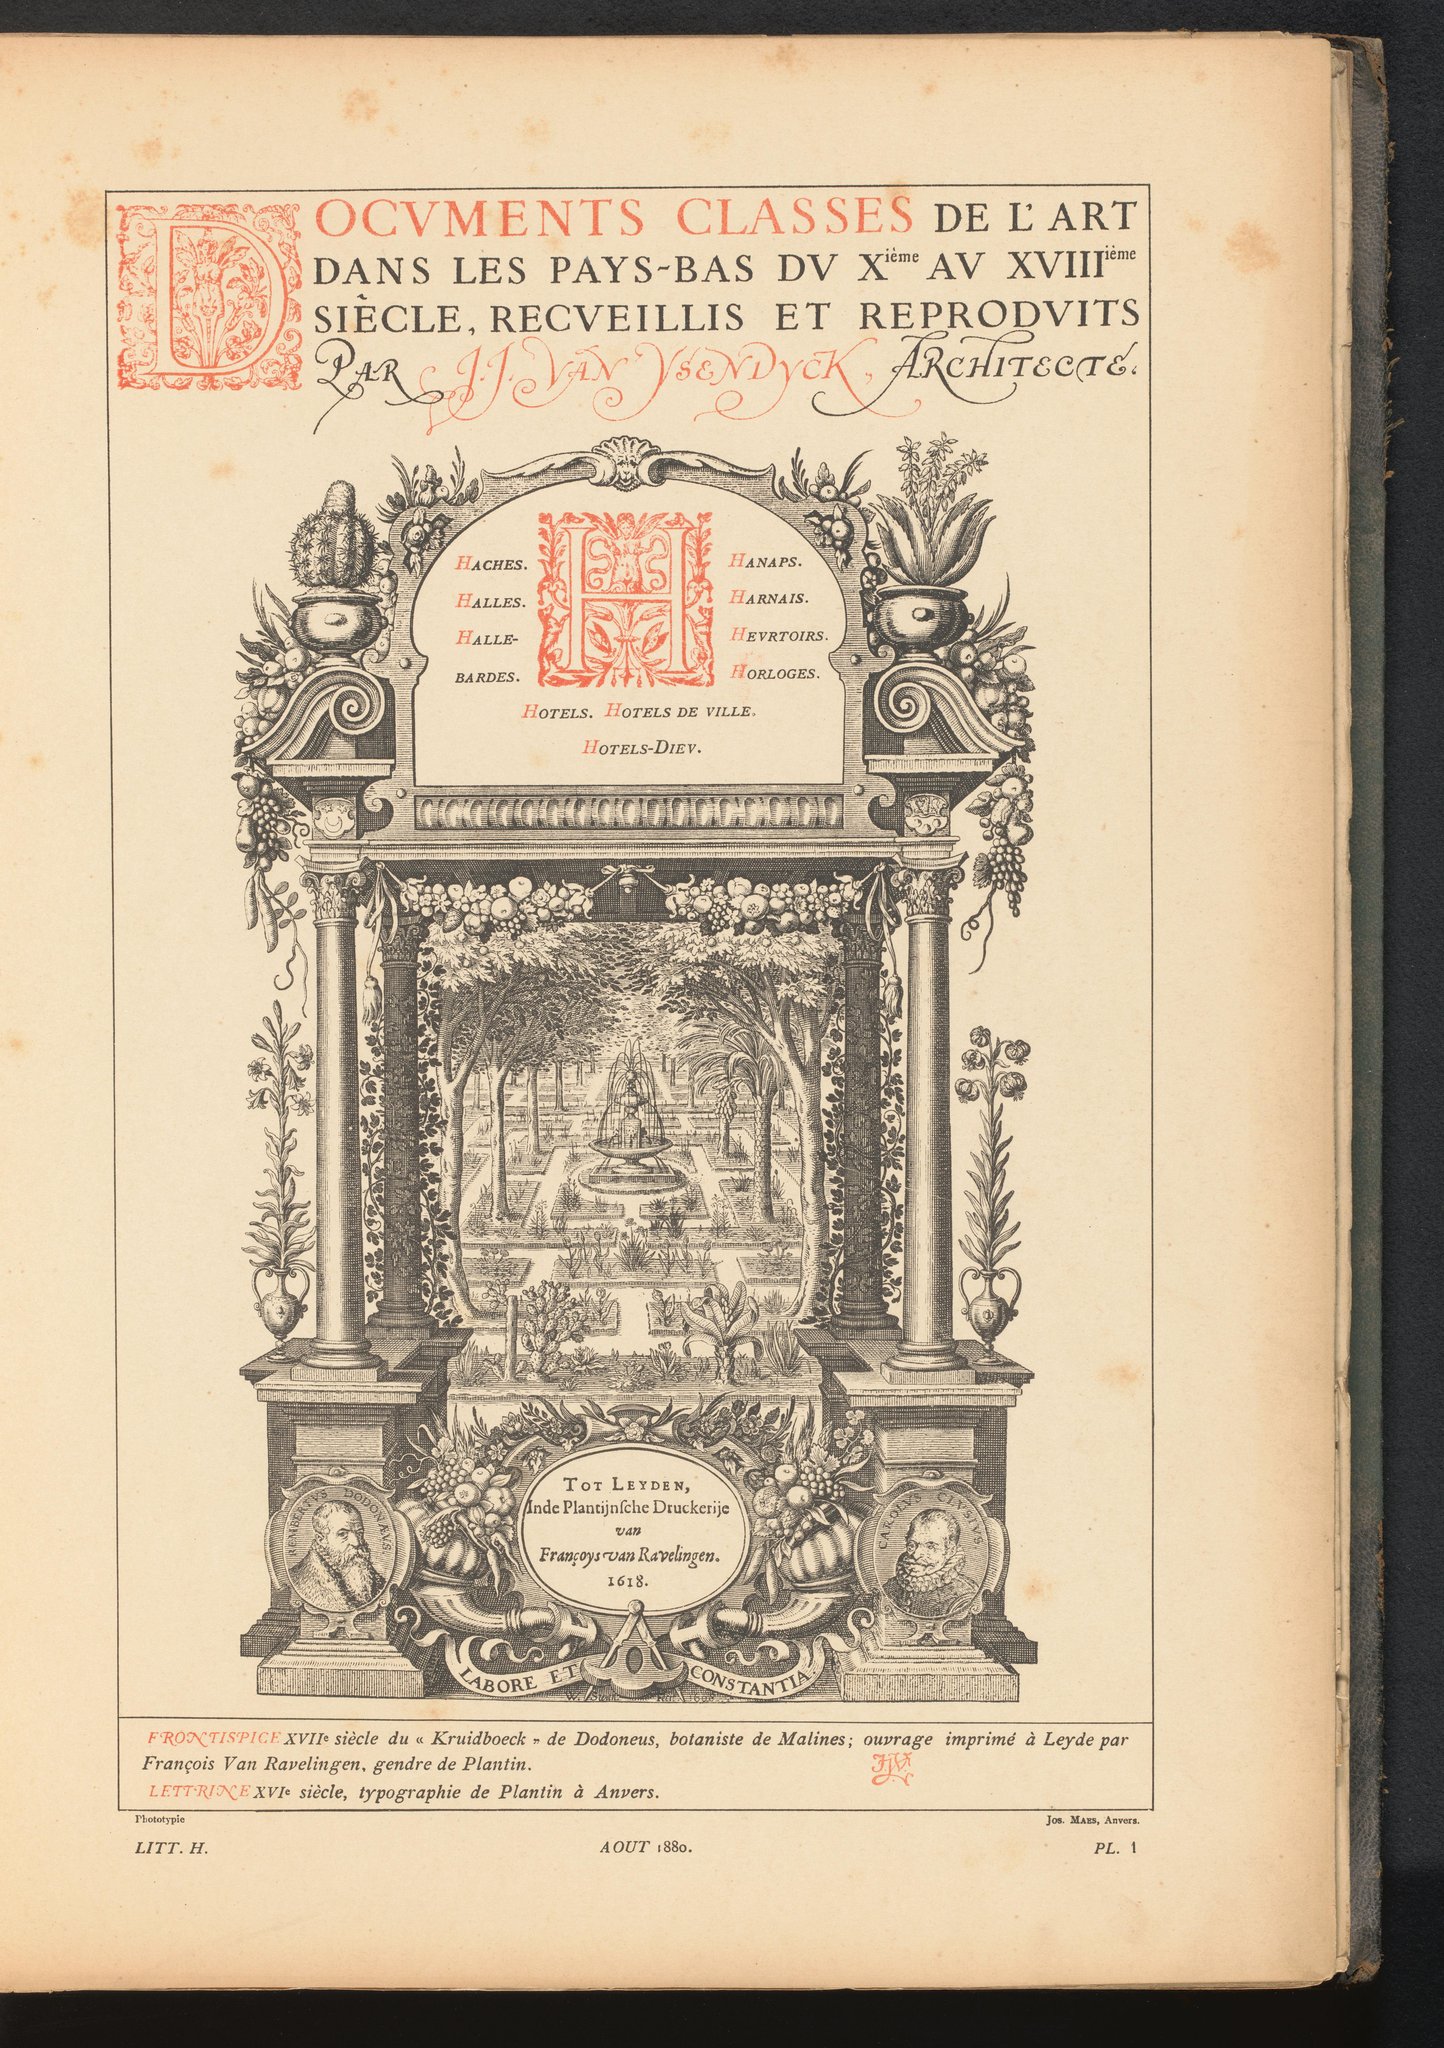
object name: page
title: Reproductie van een titelpagina van Kruidboeck van Dodoneus, met een doorkijk op een tuin, een portret van Rembertus Dodonaeus en een portret van Carolus Clusius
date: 1875-1880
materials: paper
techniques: photolithography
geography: antwerp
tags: mechelen, leiden, rembertus dodonaeus, garden, historical persons, title-page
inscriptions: inscription: ‘FRONTISPICE XVIIe siècle (...)’, monogram: ‘JJvY’, inscription: ‘LITT. H. - AOUT 1880. - PL. 1.’